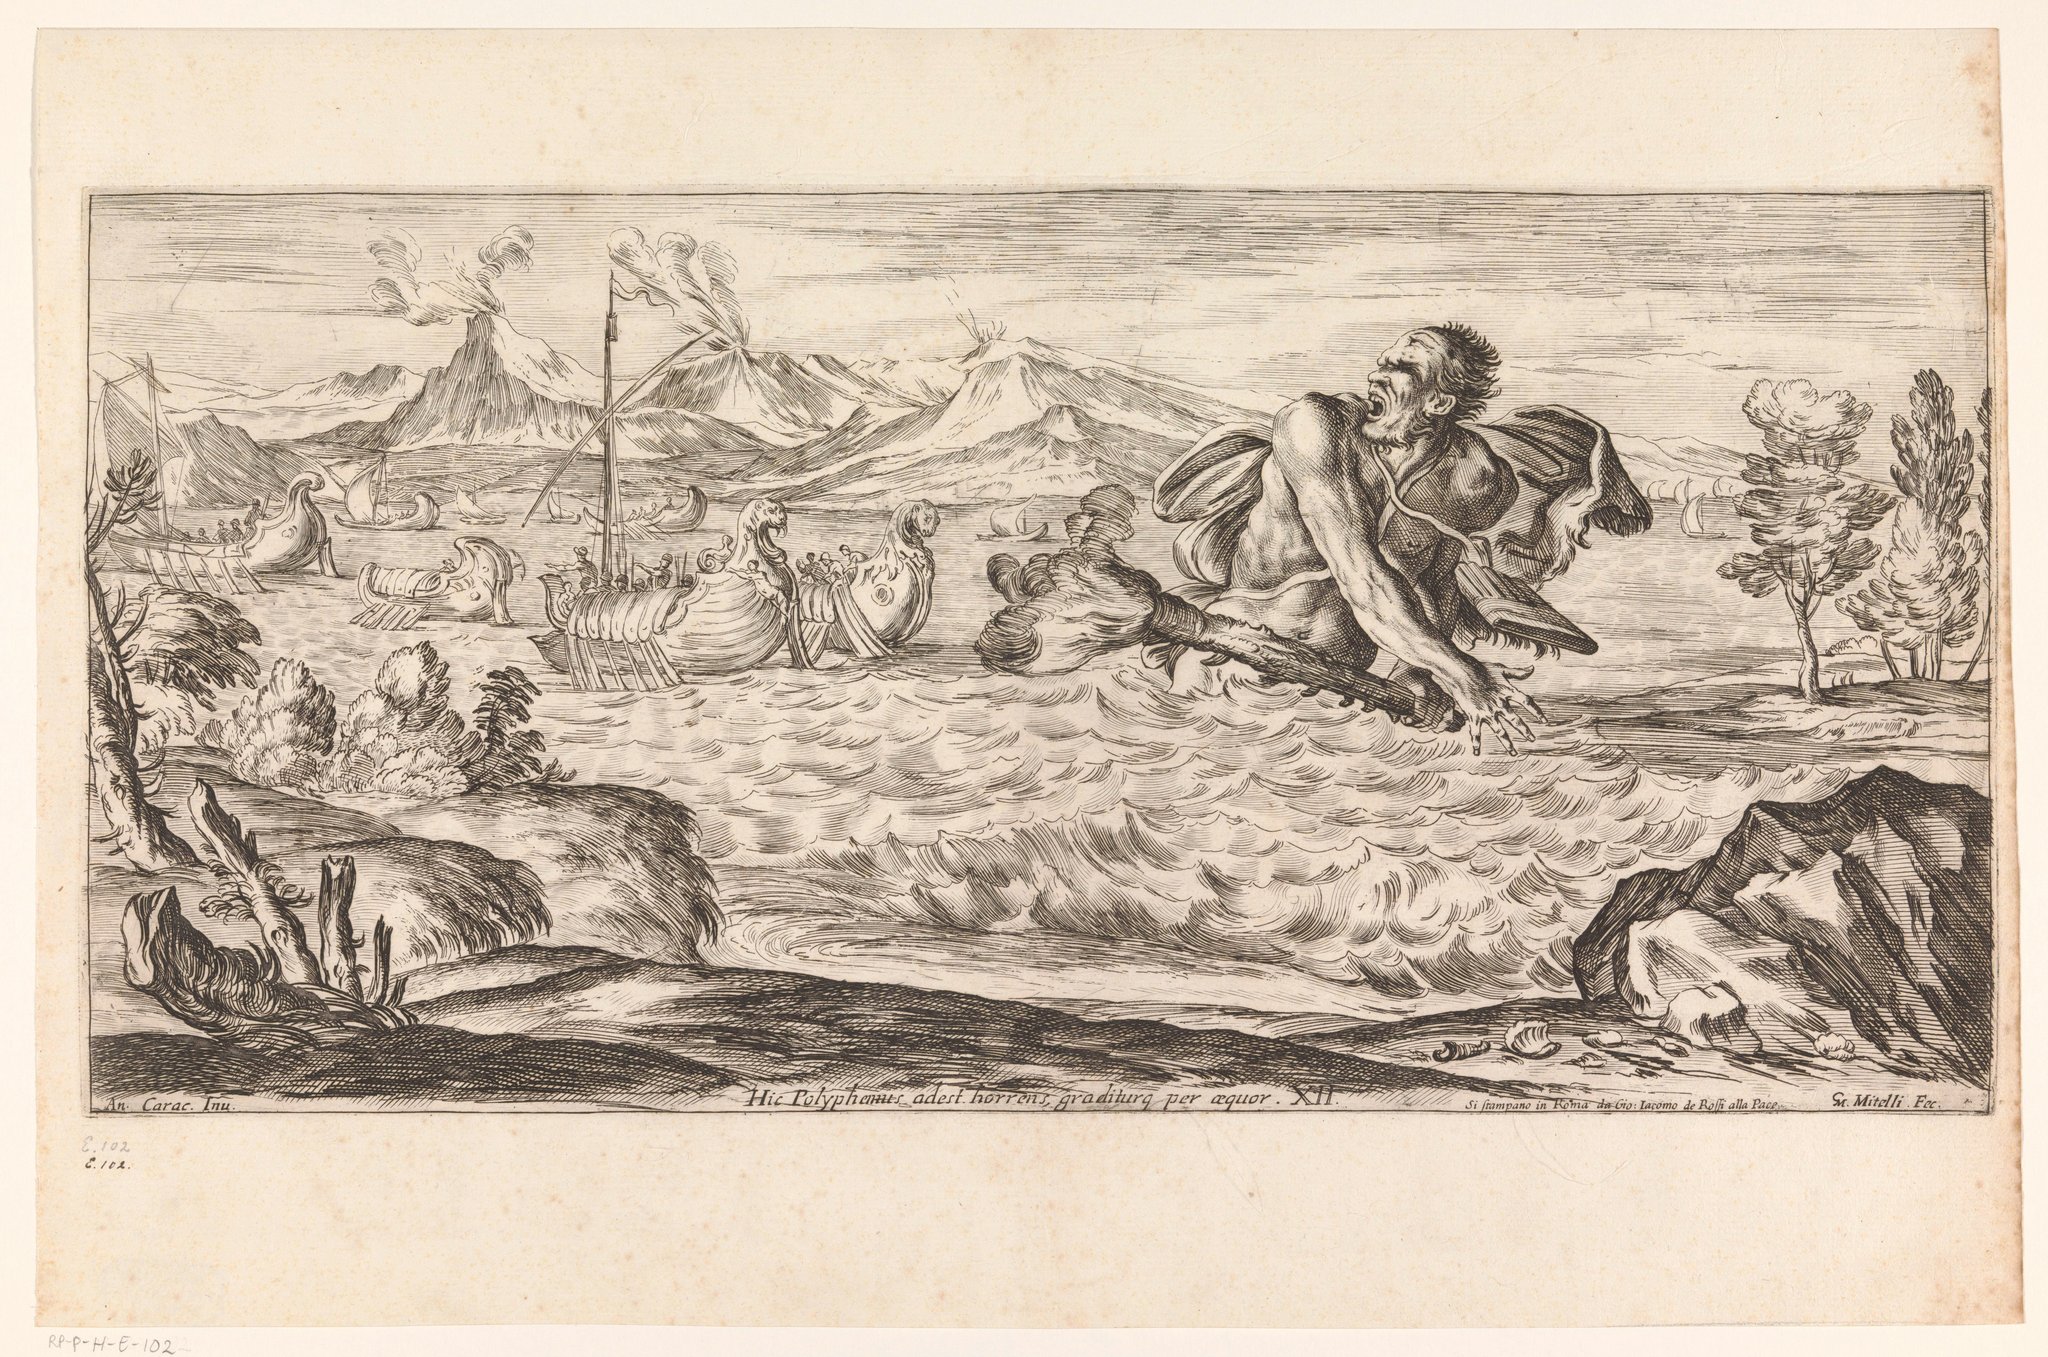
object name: print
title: Omzwervingen van Aeneas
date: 1663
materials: paper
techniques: etching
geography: italy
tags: the trojans escape from polyphemus and the cyclopes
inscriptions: collector's mark: ‘Hinloopen’, collector's mark: Lugt 11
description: Deze prent maakt deel uit van een reeks van 20 prenten (+ titelprent) naar de fresco's door de Carracci's in Palazzo Fava Ghisilieri te Bologna. Deze prent maakte oorspronkelijk deel uit van liber nr. 22 van de Atlas van Rome, uit de collectie Hinloopen. In dit album waren een aantal prentreeksen naar bekende zeventiende eeuwse frescoseries bijeengebonden. In 1709 heeft Schijnvoet op last van de burgemeesters van Amsterdam de collectie herordend. De prenten uit liber 22 kwamen terrecht in Schijnvoet boek nr. 10. De laatst gedateerde reeks in het album is gedateerd 1691. Het album moet dus na deze datum gebonden zijn. De band is in de Rijksakademietijd uit elkaar gehaald. De marges van de prenten zijn bij het opbergen in het Rijksprentenkabinet vaak drastisch afgesneden. Van een aantal series waren de prenten teruggeslagen om in het album te passen. (Zie: Waals, Jan van der. De prentschat van Michiel Hinloopen. 's-Gravenhage: SDU uitgeverij, 1988, pp. 173-174.)